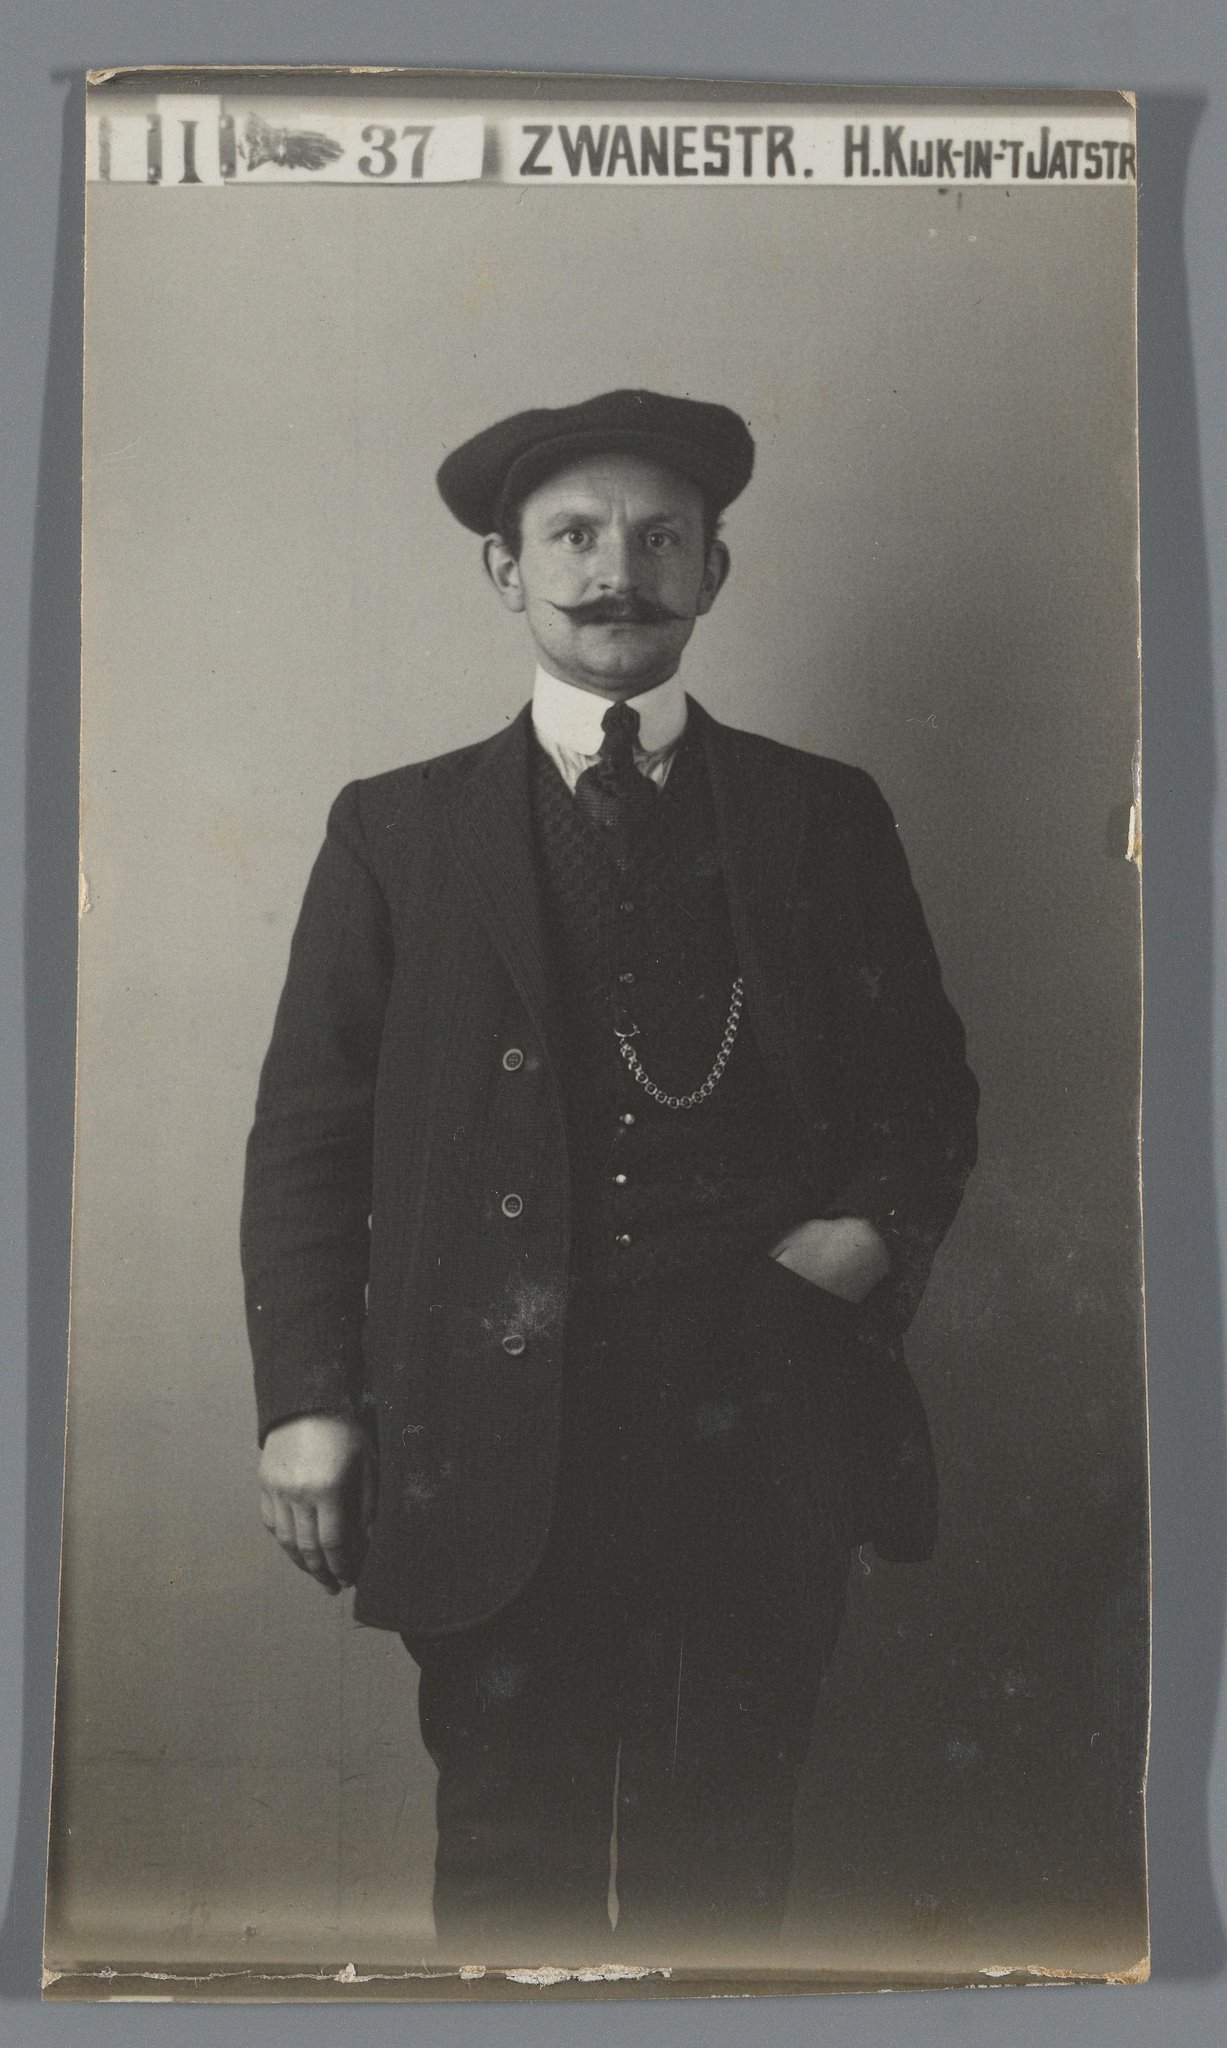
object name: snapshot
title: Portret van een man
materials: photographic support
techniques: gelatin silver print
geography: groningen